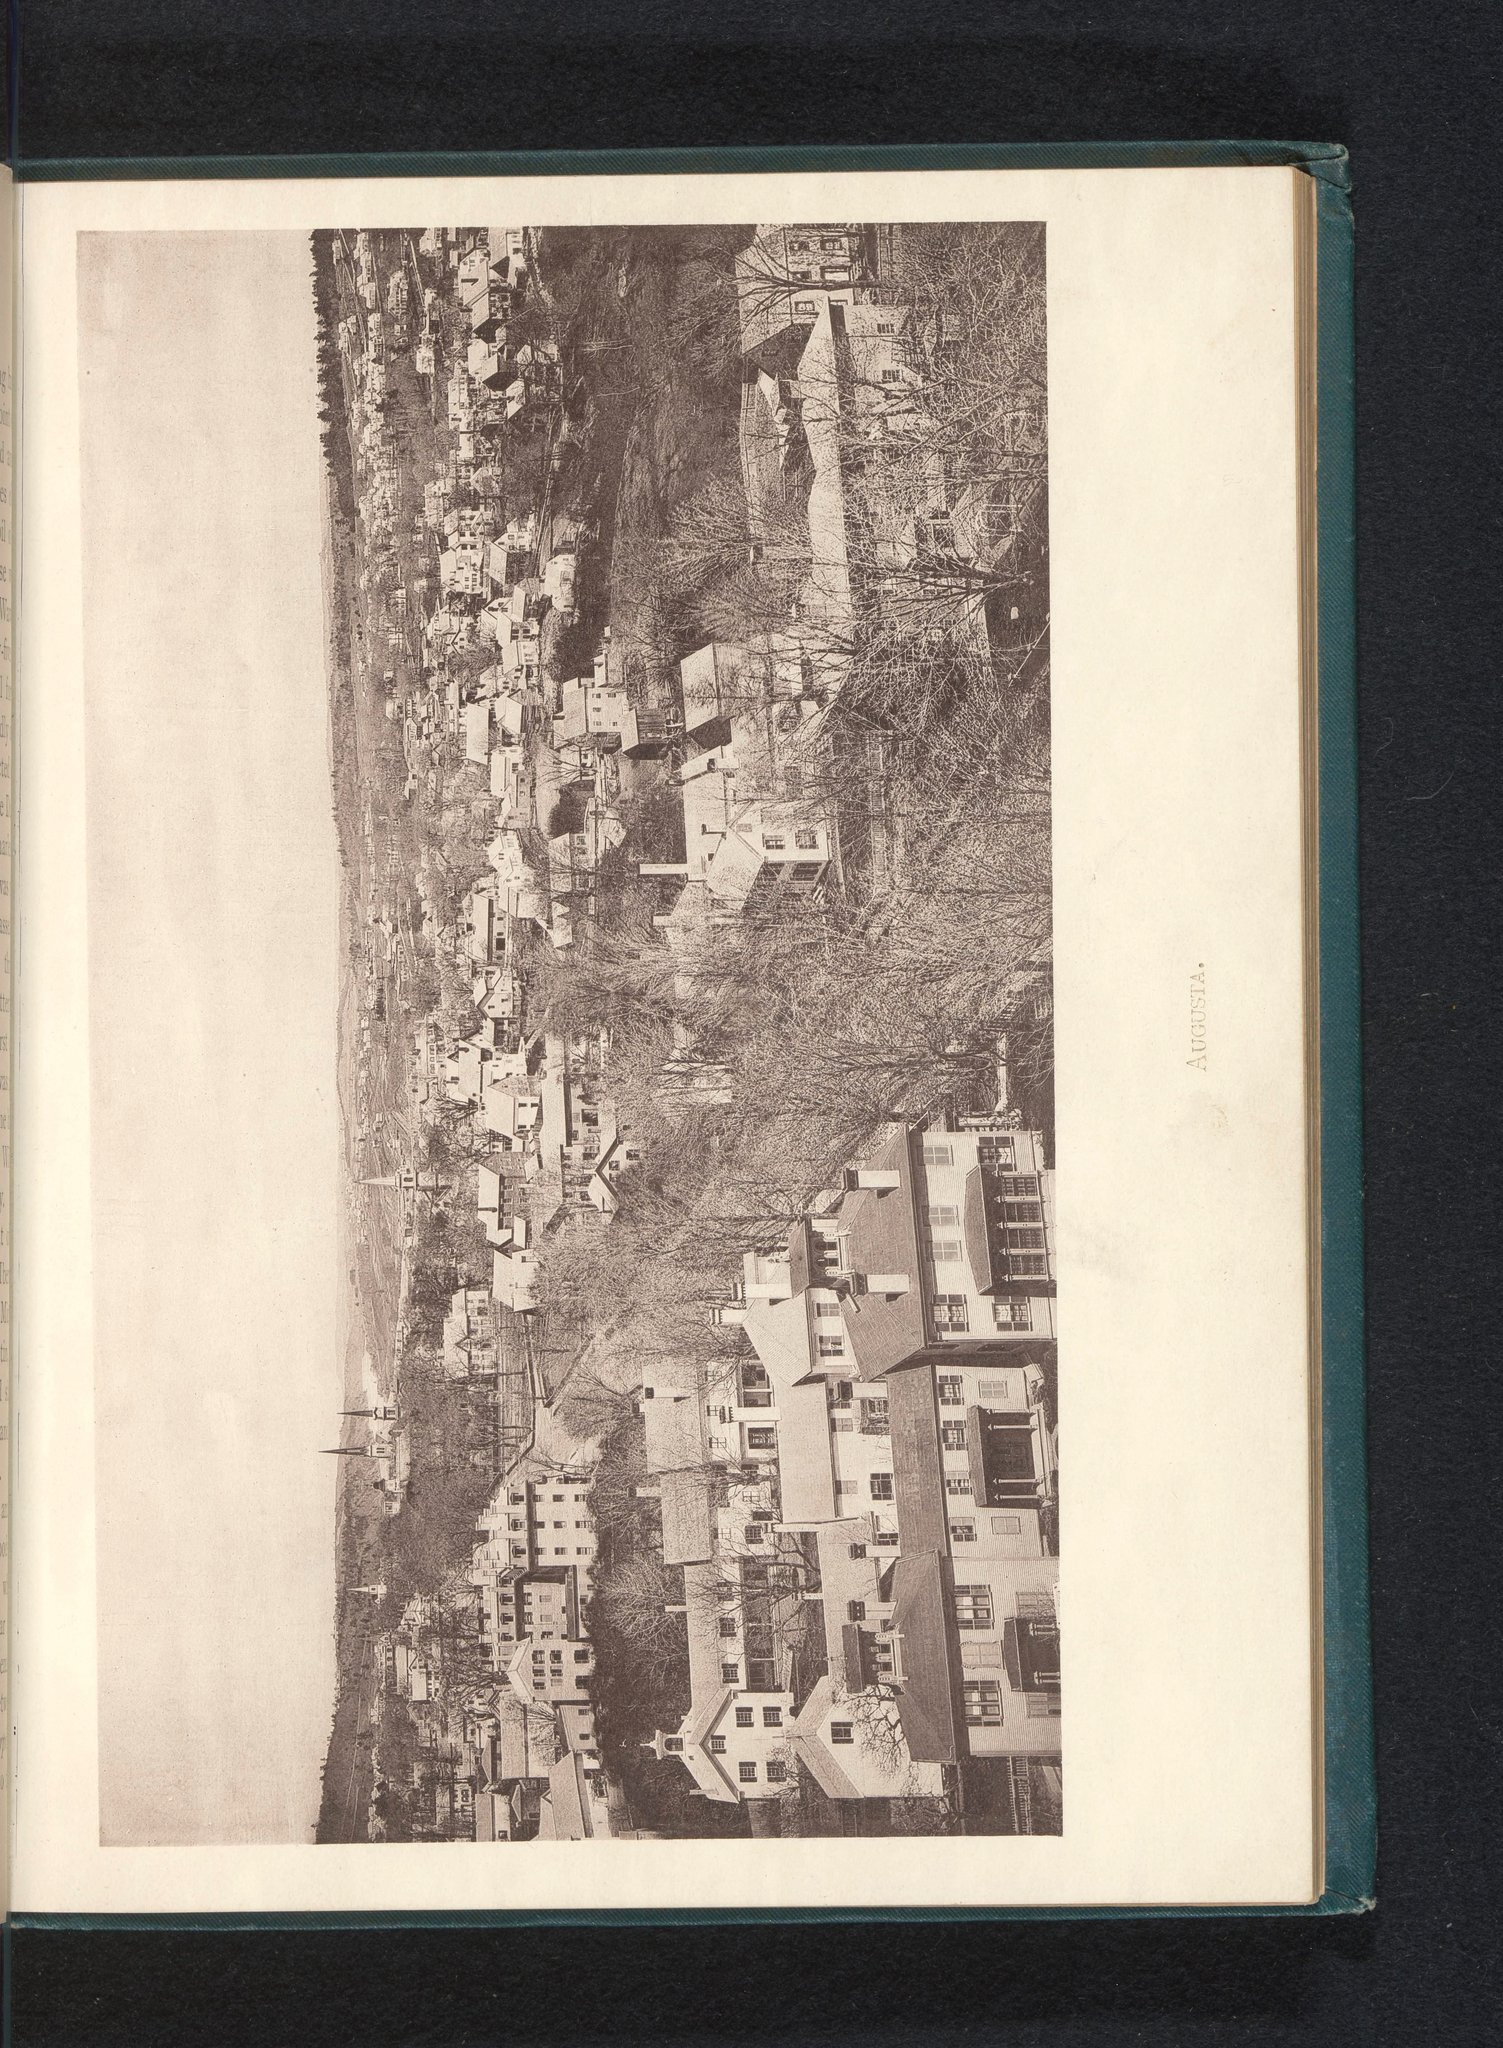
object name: page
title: Augusta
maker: Anonymous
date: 1875-1880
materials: paper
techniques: photograph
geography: augusta (maine)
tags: city-view, and landscape with man-made constructions